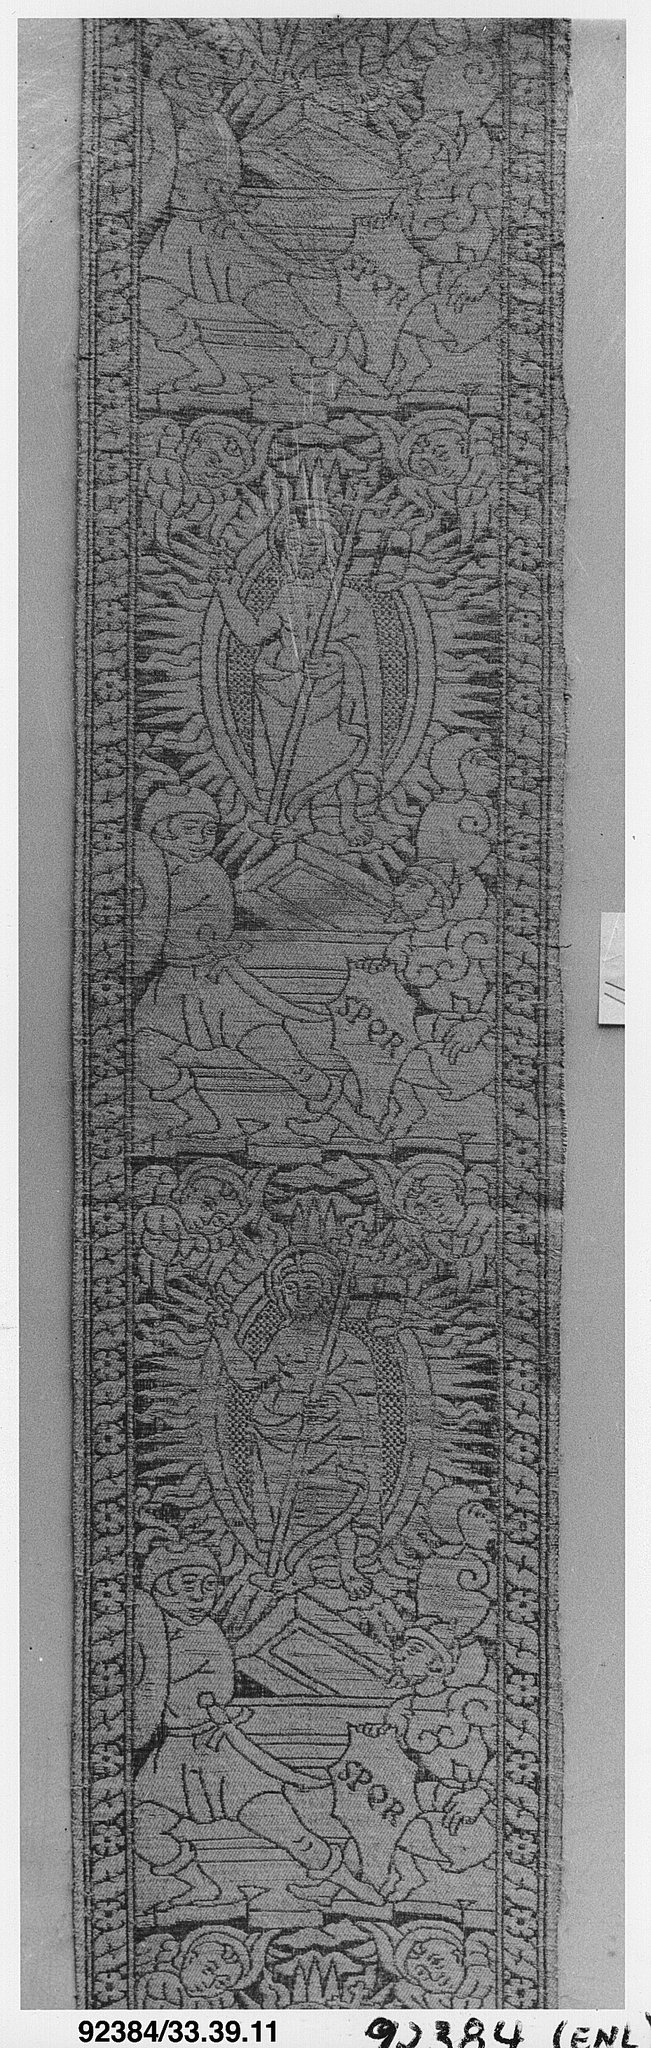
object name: orphrey fragment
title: Orphrey woven with figurative repeat design of the Resurrected Christ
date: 1401-1600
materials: linen, silk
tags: swords,men,jesus